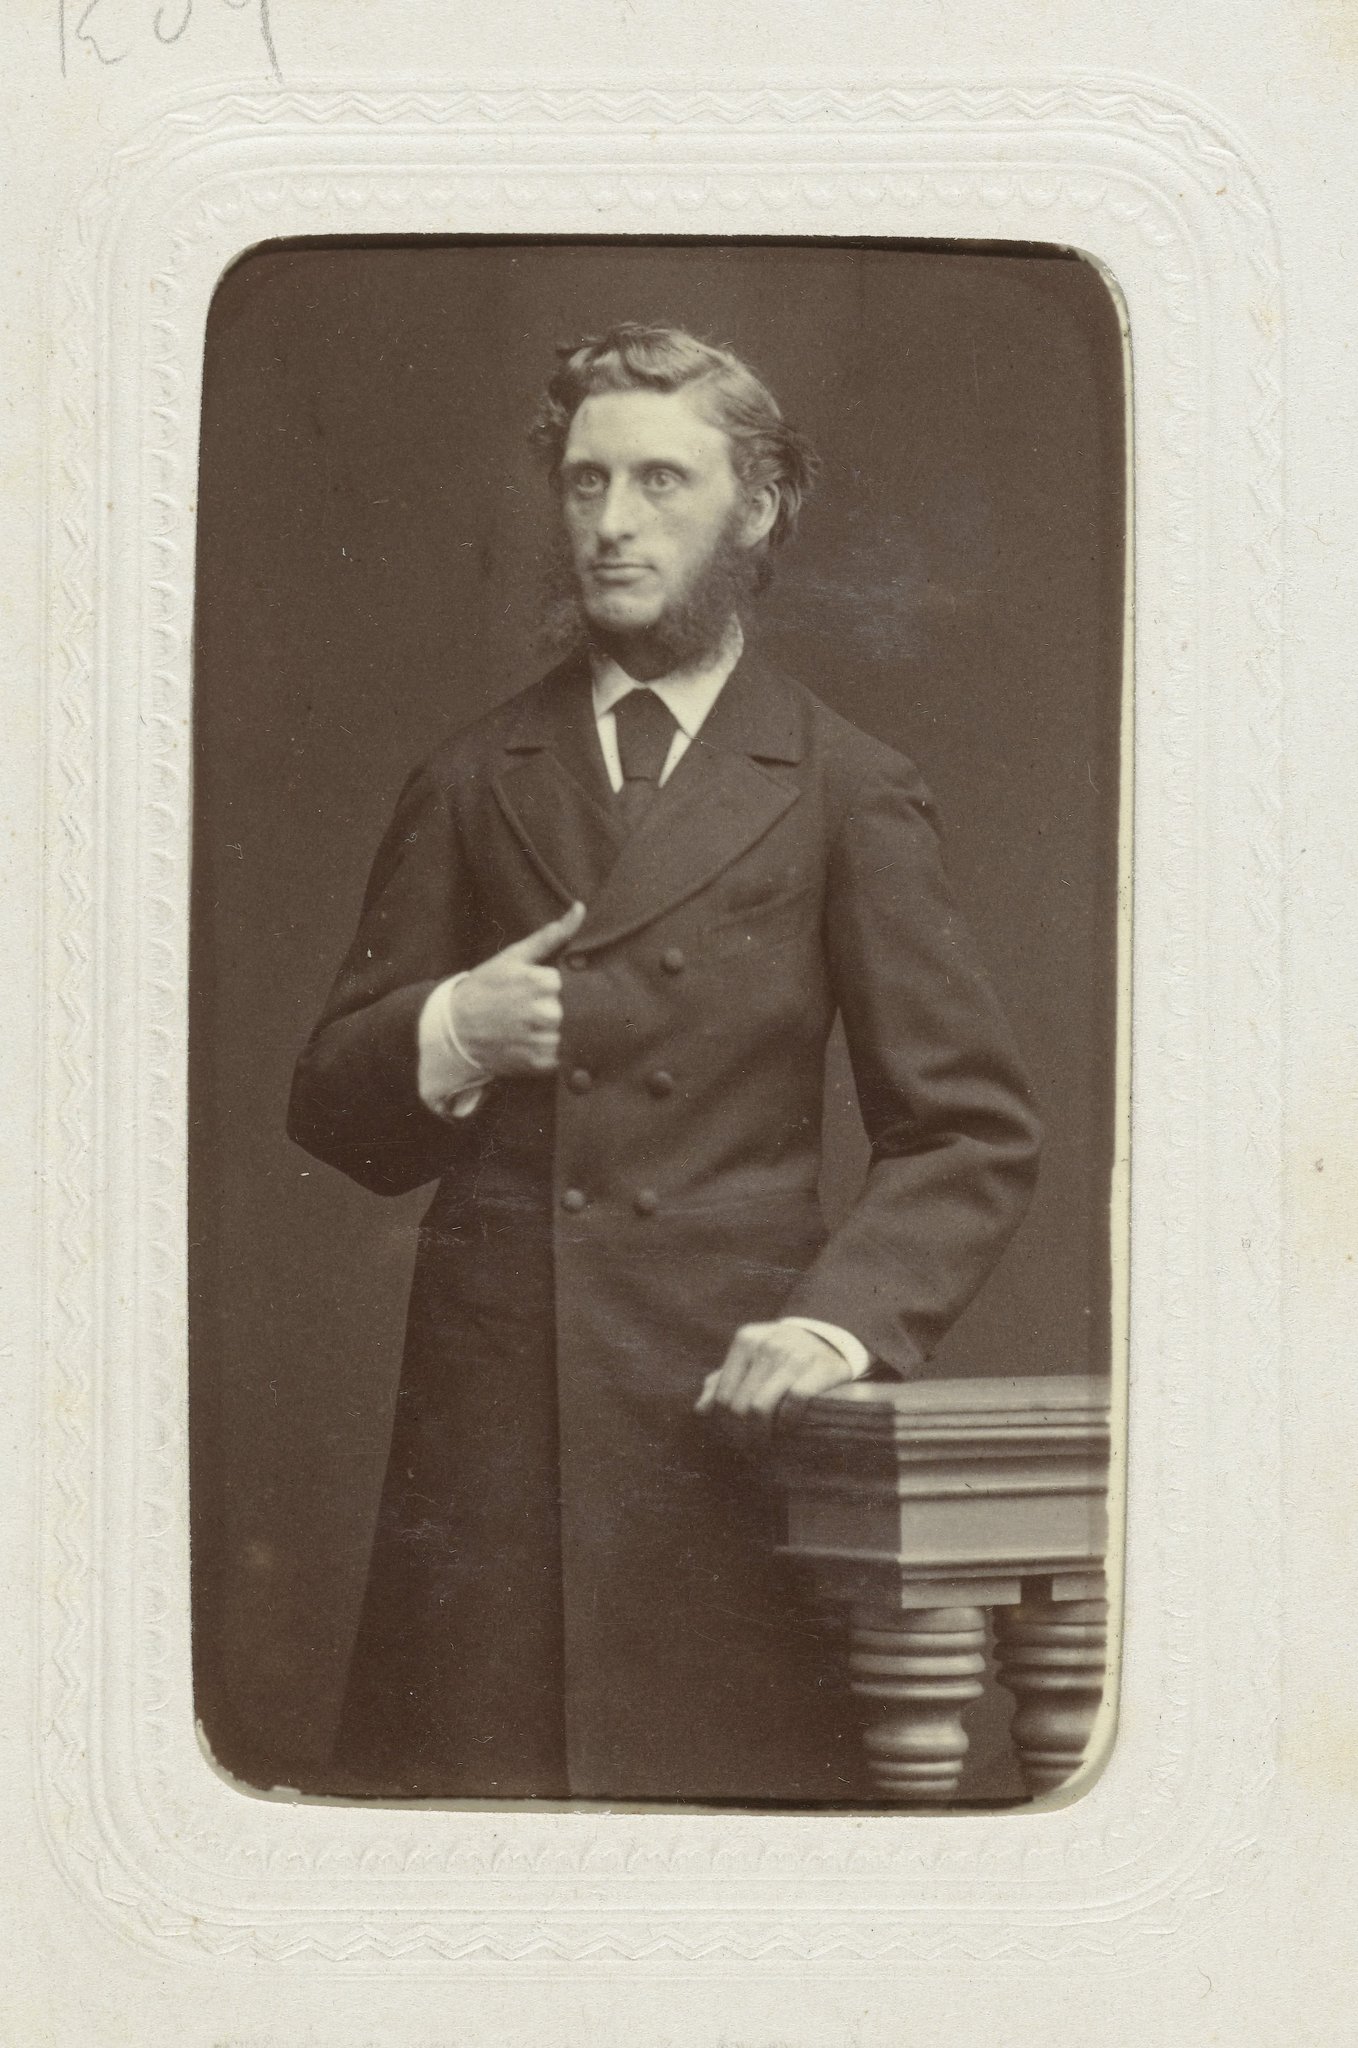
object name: carte de visite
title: Studioportret van een man met grote bakkebaarden uitlopend in een baard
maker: willem gerhardus kuijer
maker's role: fotograaf, hoffotograaf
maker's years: 1834-1899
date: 1863-1866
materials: cardboard, paper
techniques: albumen print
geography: amsterdam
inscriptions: name: ‘W.G. Kuijer, Amsterdam’